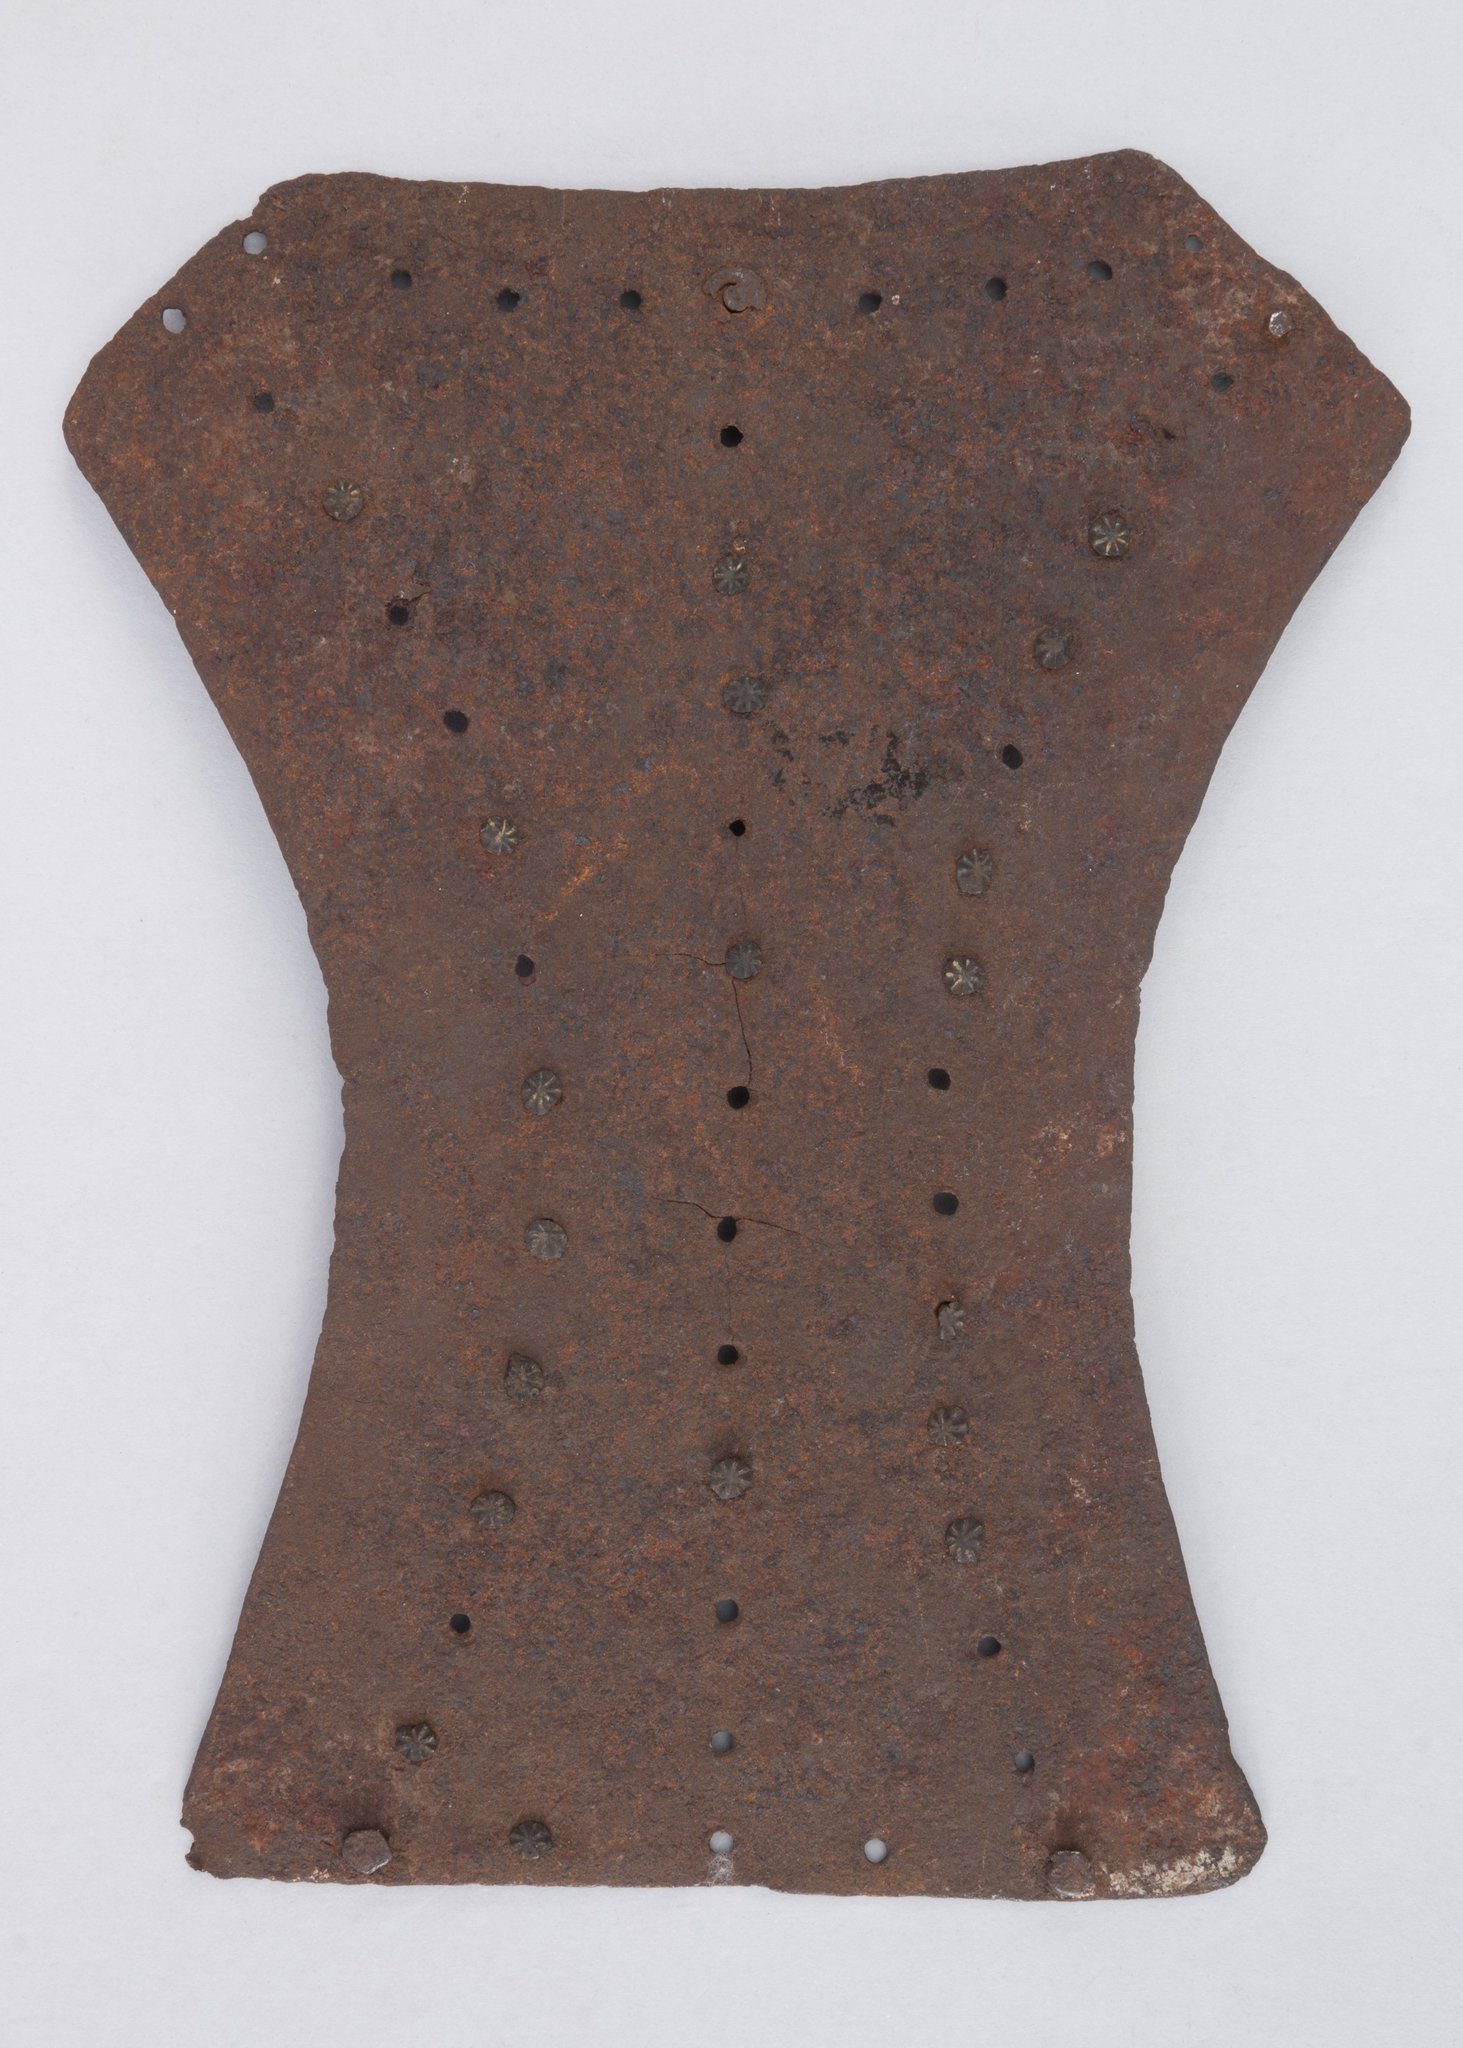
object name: brigandine plate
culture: italian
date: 1400-1450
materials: metal alloy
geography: italy